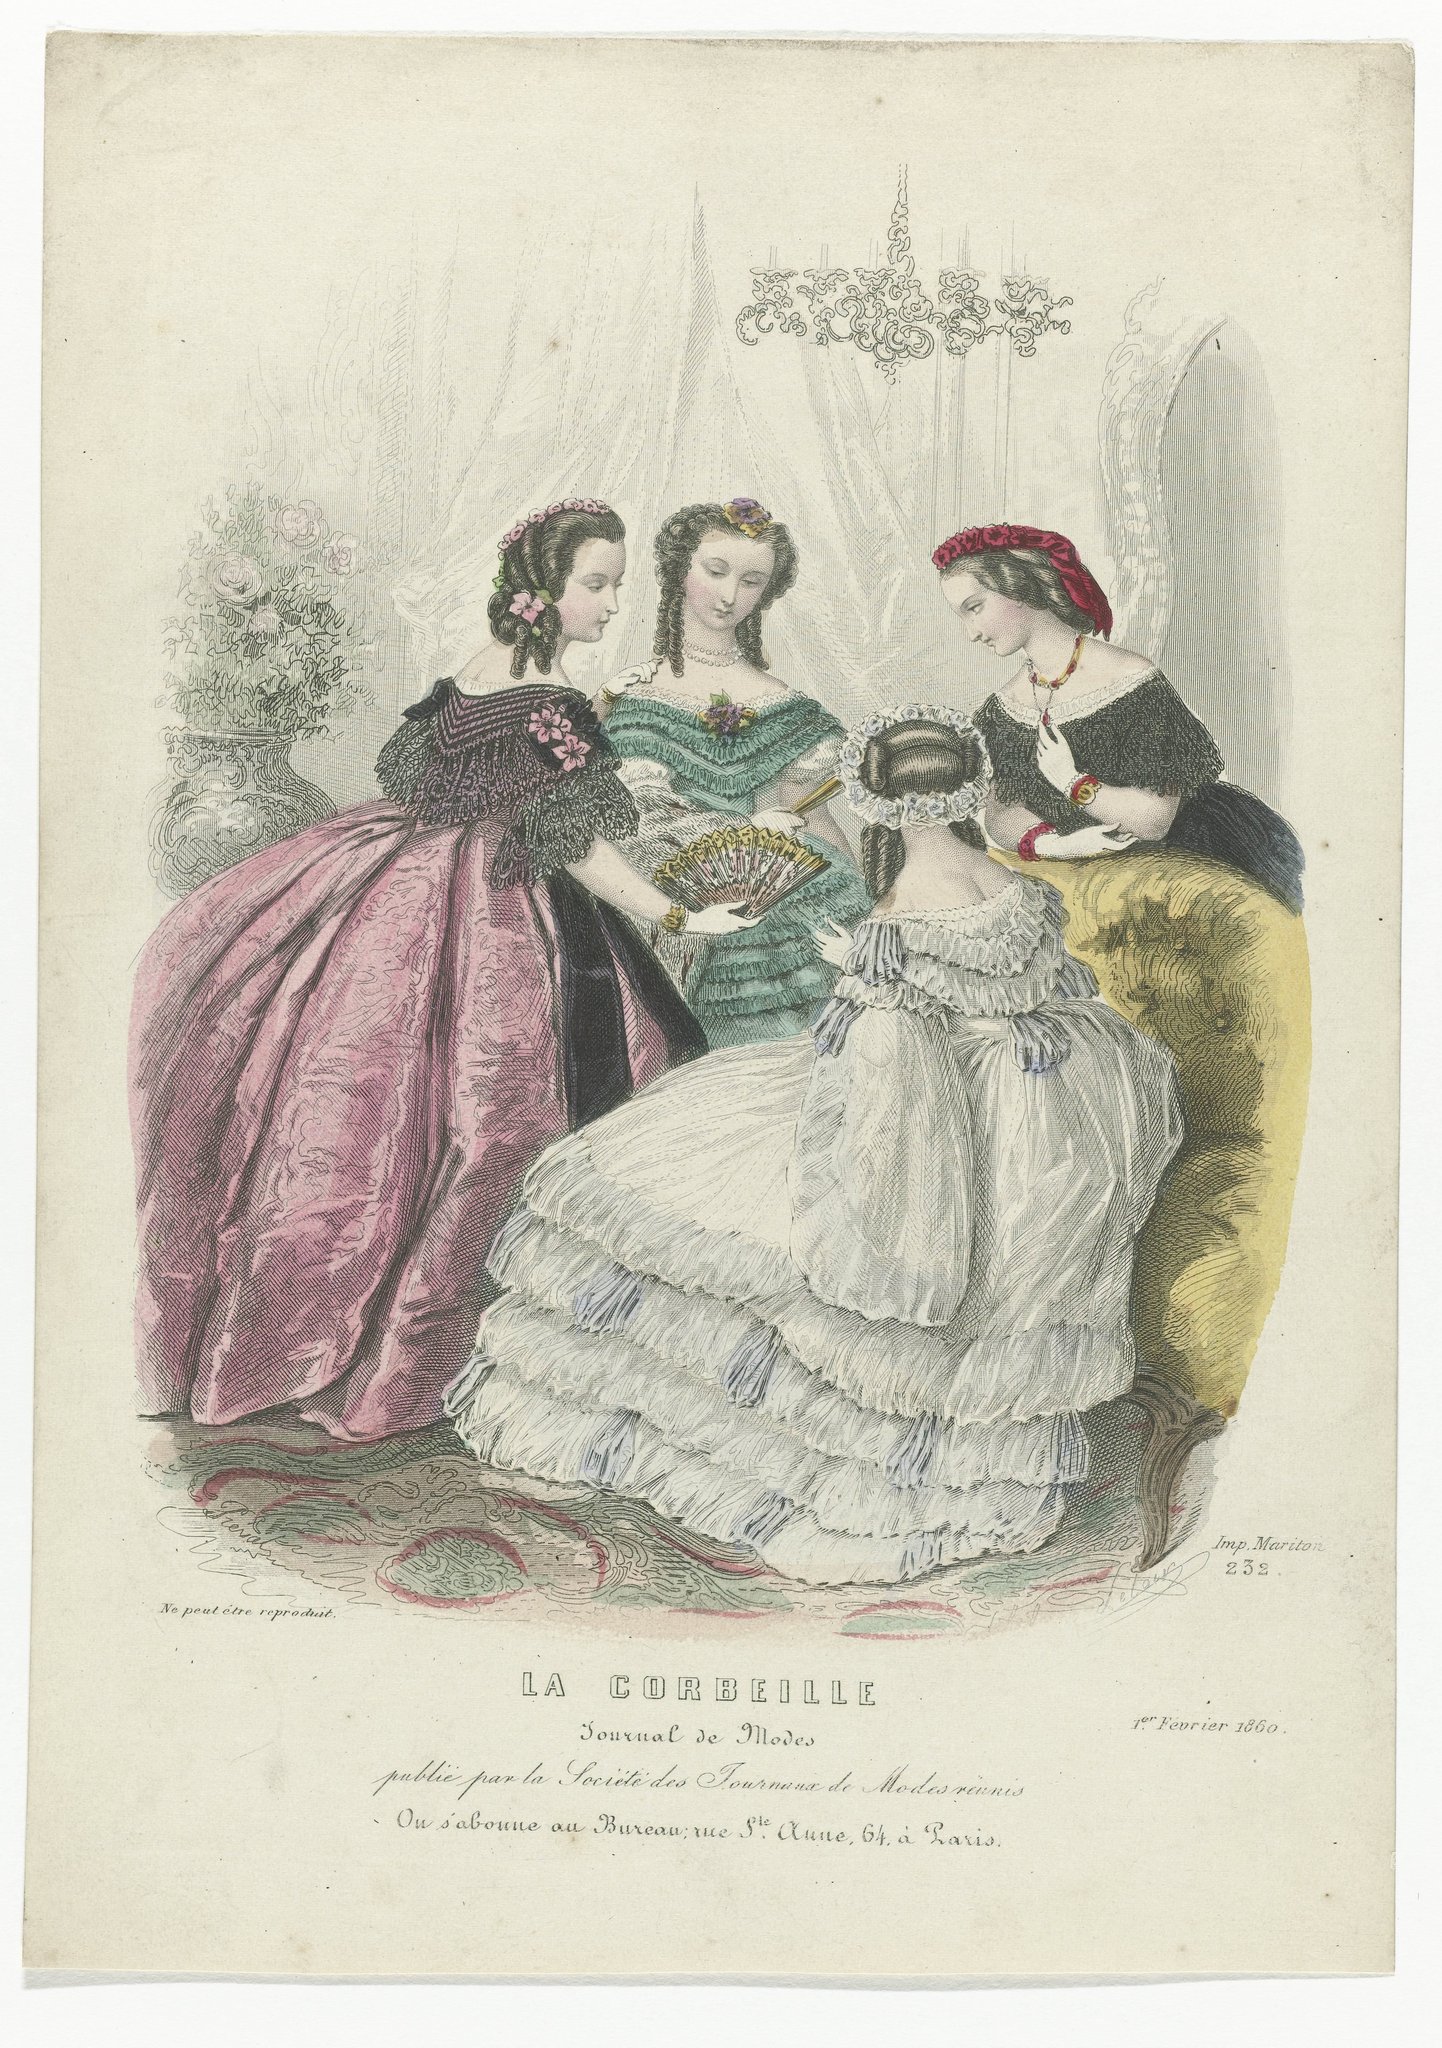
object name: fashion print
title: La Corbeille, 1 février 1860, No. 232 : Journal de Modes (...)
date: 1860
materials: paper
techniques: hand coloring, engraving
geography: paris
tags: corsage (+ women's clothes), flowers, pendant, trinket, 'breloque' (+ women's clothes), dress, gown: evening dress (+ women's clothes), gloves, mittens (short gloves) (+ women's clothes), styles of hairdress - aa - ~ women, fashion plates, fan (+ women's clothes), bracelet, wristlet (+ women's clothes)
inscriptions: caption: ‘publié par la Société des Journaux de Modes réunis’, address: ‘On 's abonne au Bureau: rue S.te Anne, 64, à Paris.’, title: ‘La Corbeille / Journal de Modes’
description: Vier vrouwen in avondkleding in een interieur. Één van hen toont haar opengeklapte vouwwaaier. Onder de voorstelling enkele regels informatie over het modetijdschrift. Prent uit het modetijdschrift La Corbeille (1840-1878).